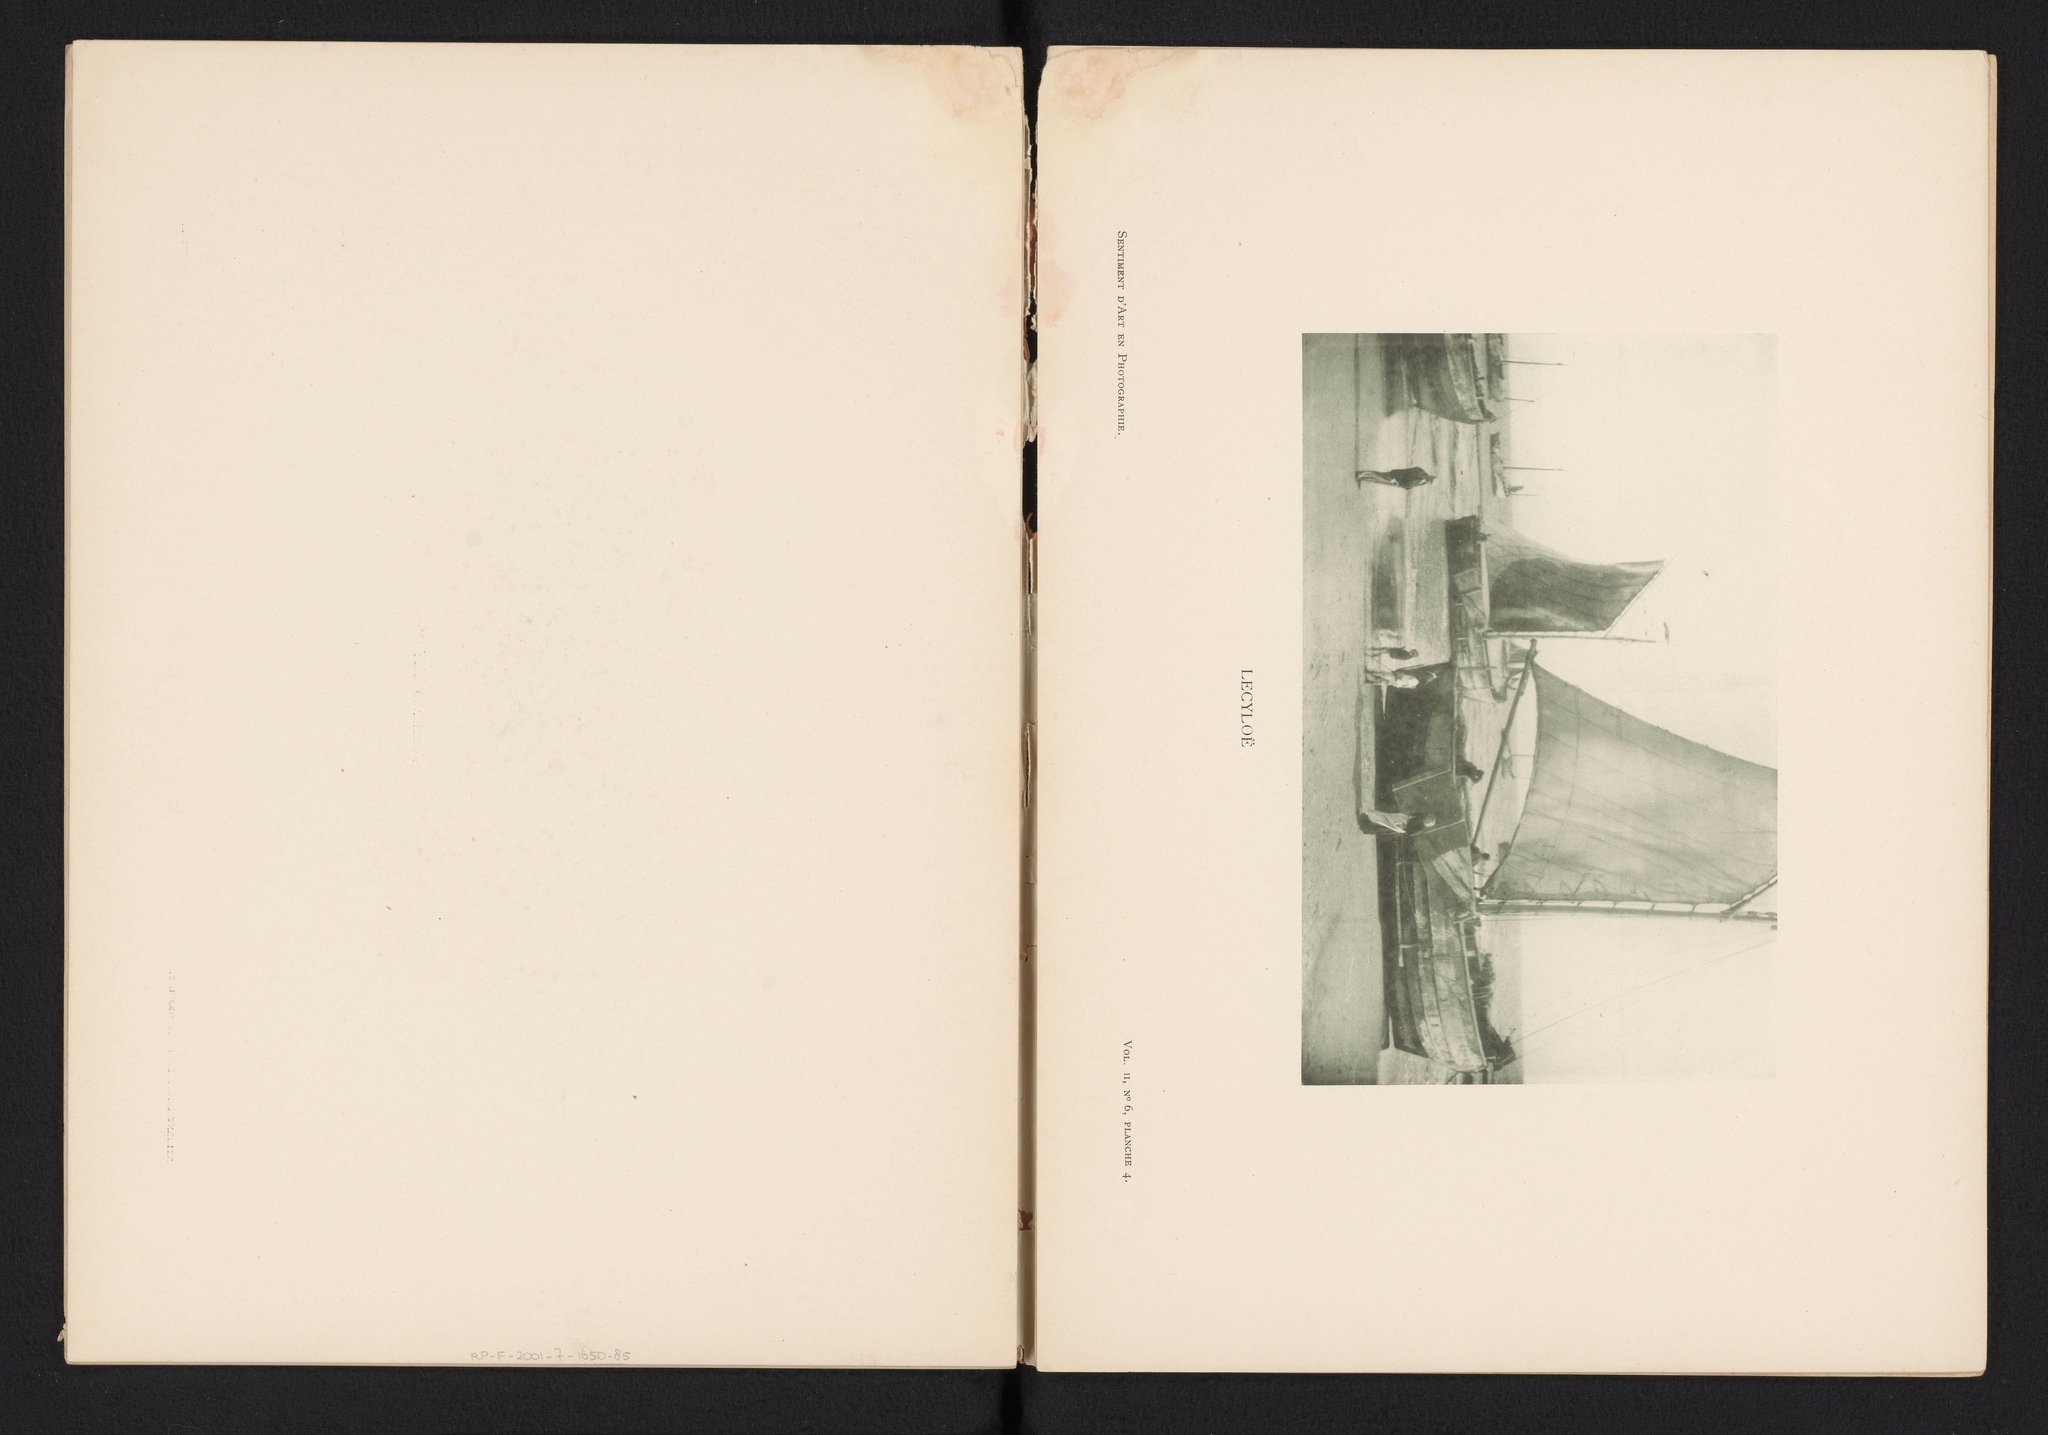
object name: photomechanical print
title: Zeilschepen in de branding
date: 1895-1900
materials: paper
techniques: photograph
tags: sailing-ship, sailing-boat, surf, breakers, beach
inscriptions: number: ‘Vol. II, No 6, Planche 4.’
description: Deze prent maakt deel uit van 8 omslagen met 22 tekstbladen en 89 prenten op losse bladen in en tussen de omslagen.